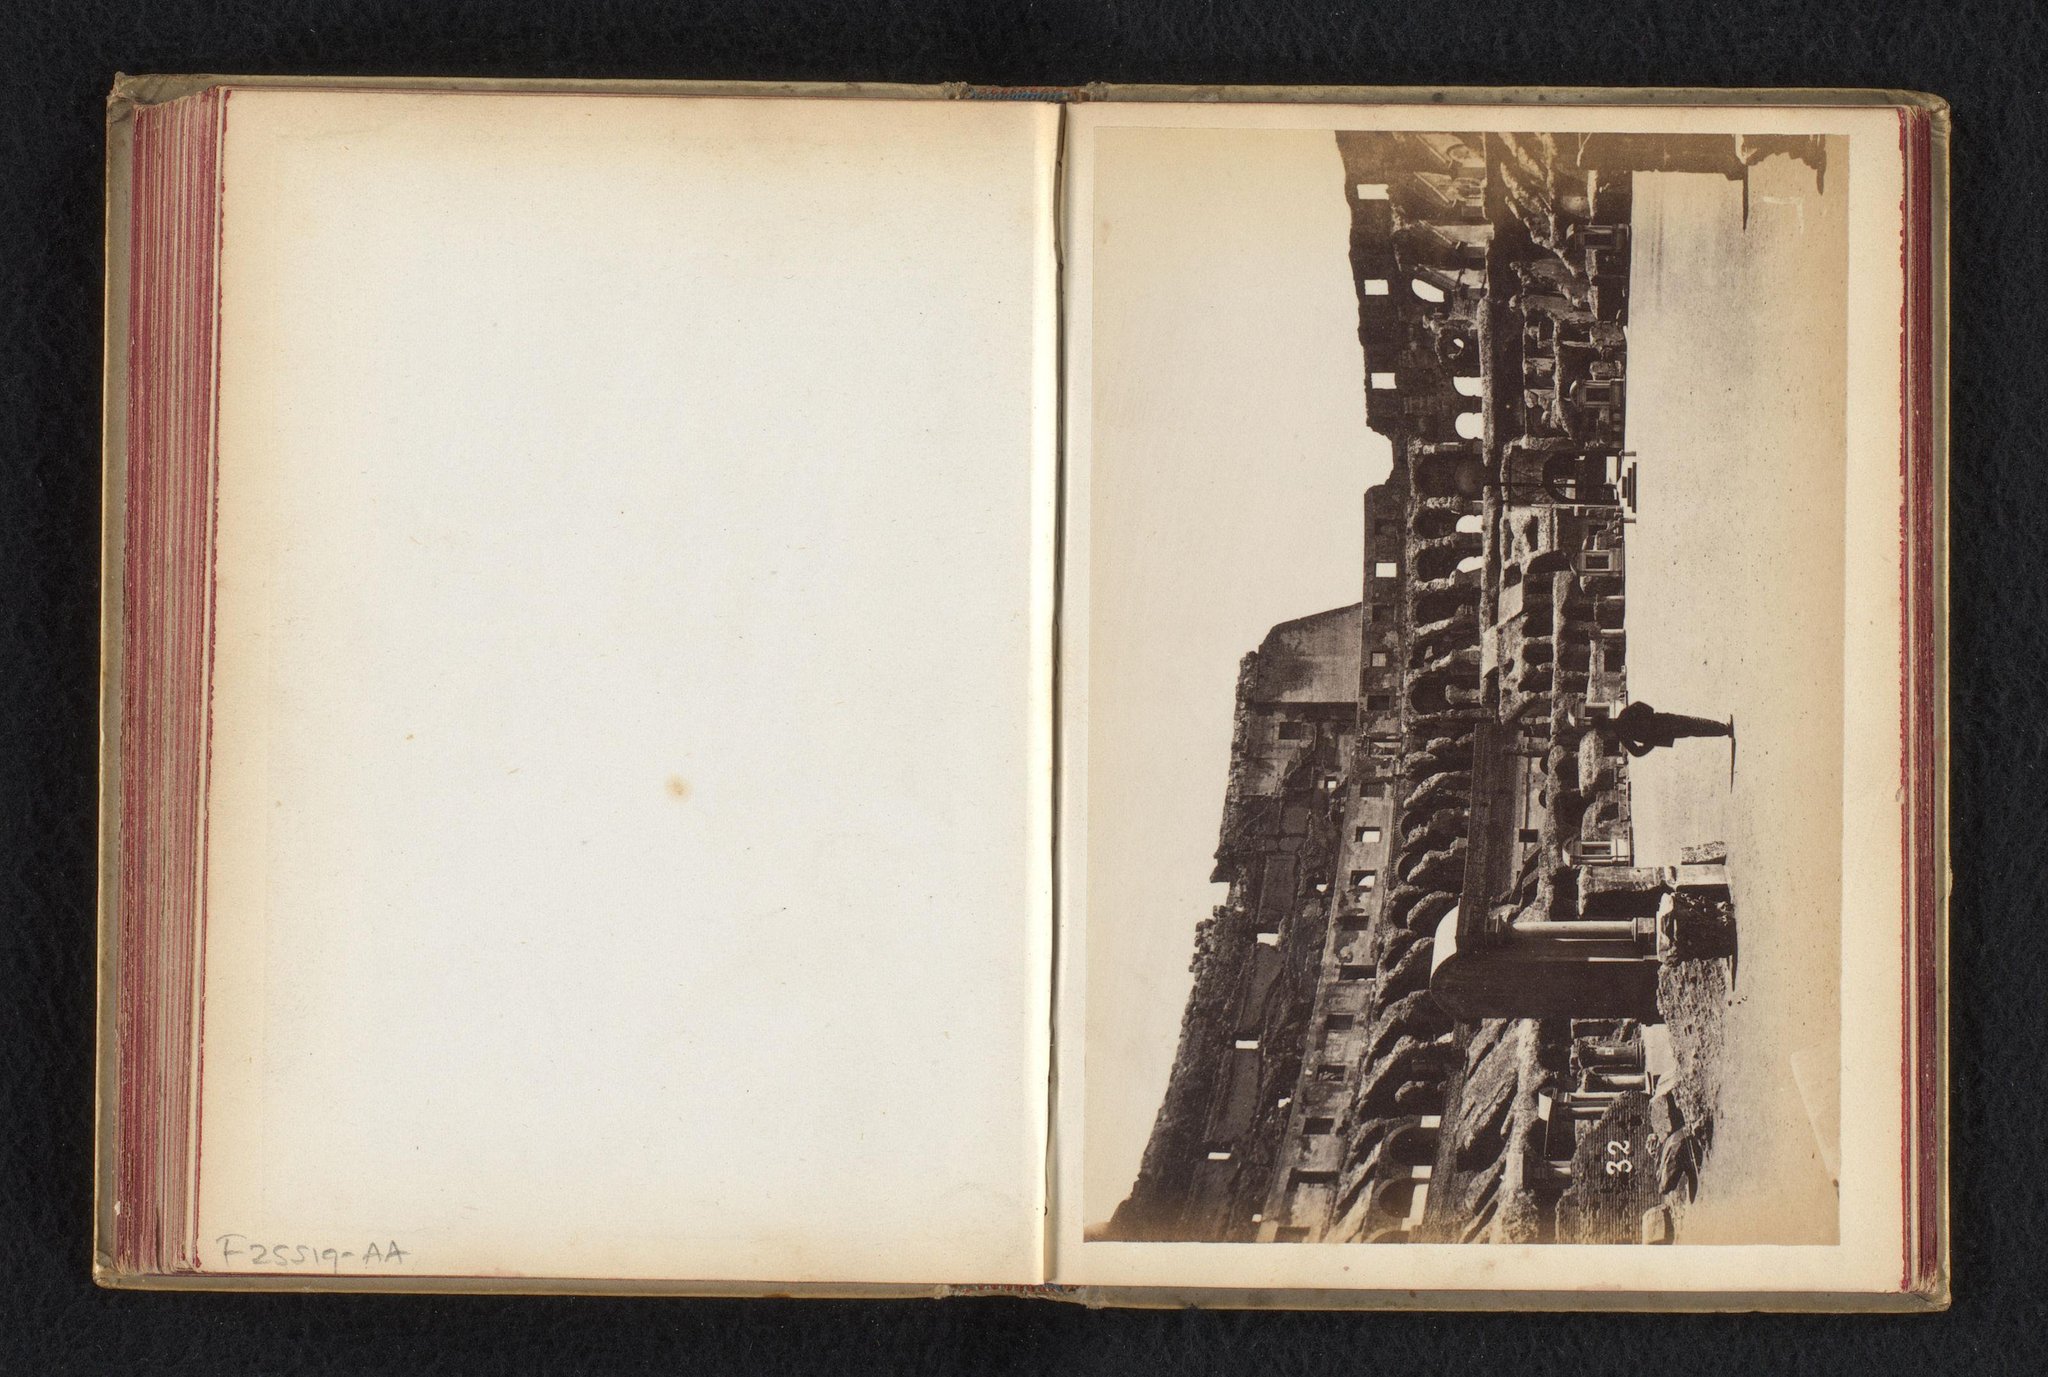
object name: photograph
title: Binnenkant van het Colosseum, Rome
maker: Anonymous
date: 1851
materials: paper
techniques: albumen print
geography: rome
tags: amphitheatre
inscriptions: number: ‘32’